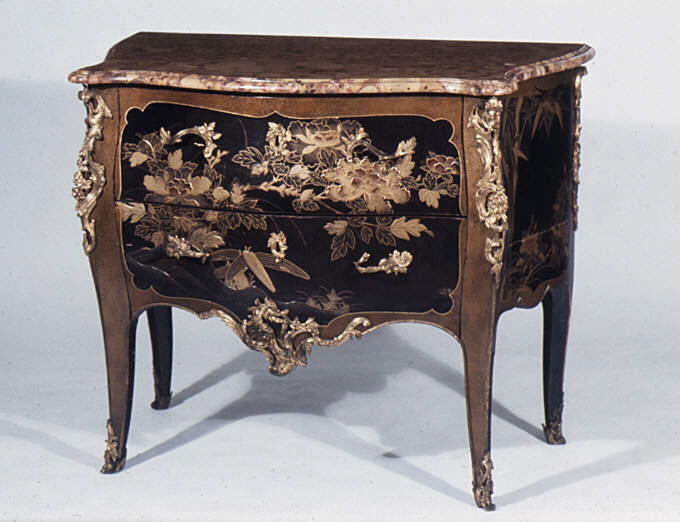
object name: commode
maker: jacques dubois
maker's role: maker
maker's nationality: french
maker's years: 1694-1763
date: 1745-1749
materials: gilt bronze, lacquer, marble, wood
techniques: gilding, painting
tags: flowers